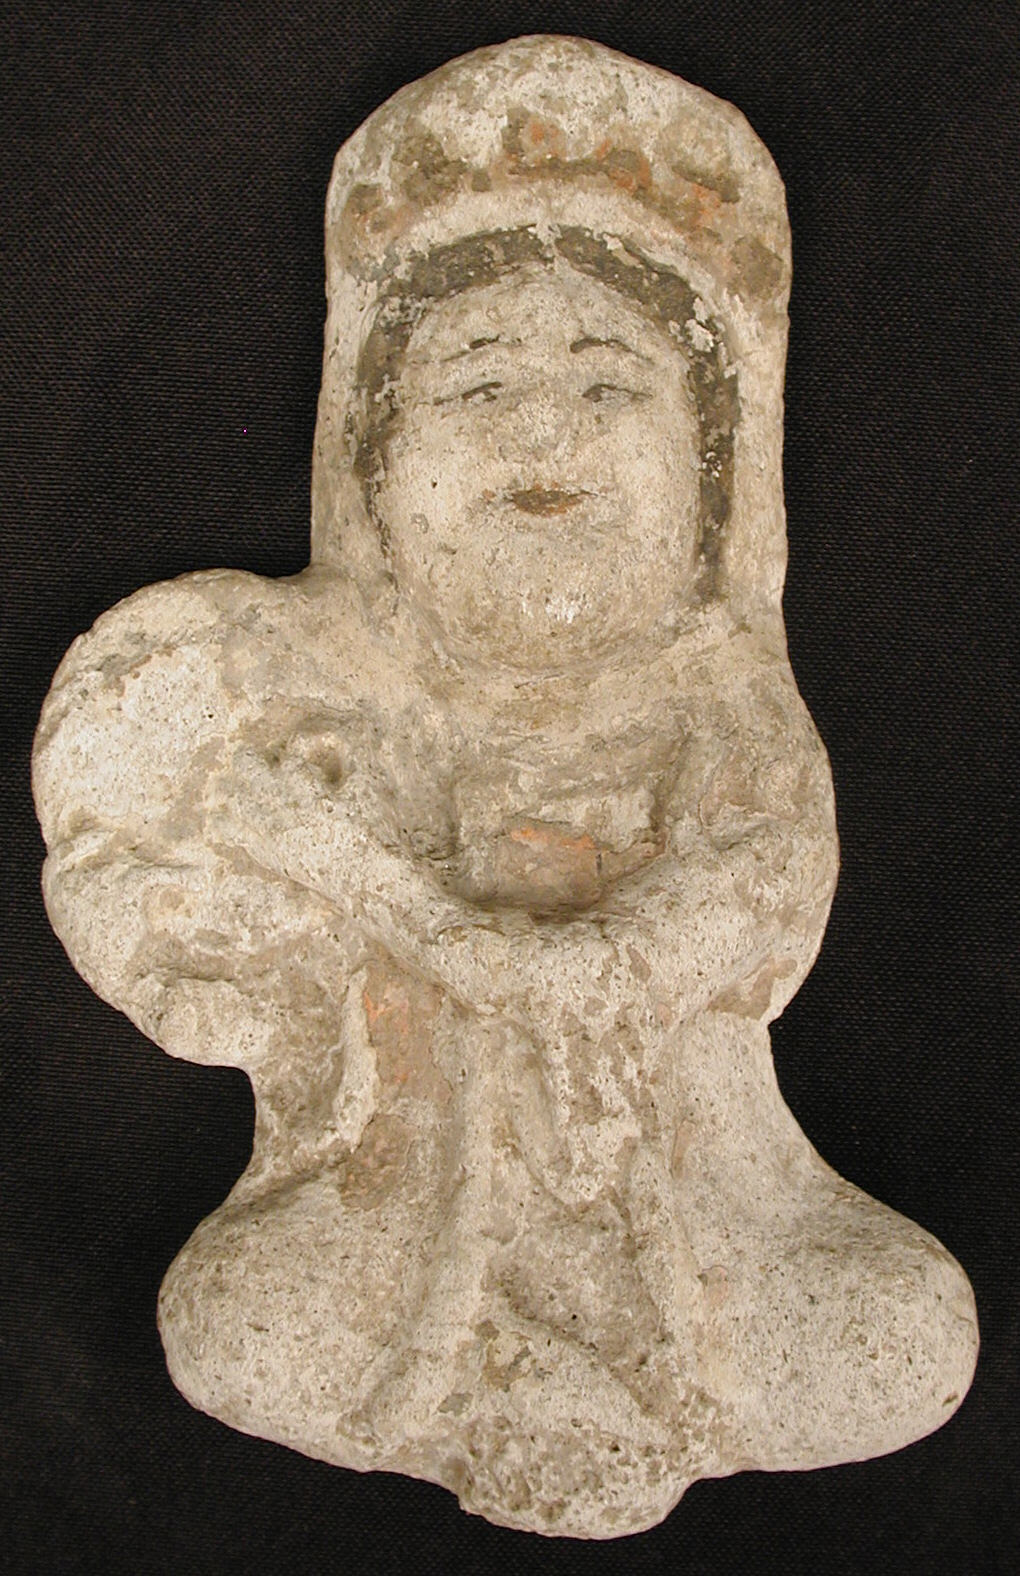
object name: figure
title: Seated Tambourine Player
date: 1101-1200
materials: plaster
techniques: molding, painting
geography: iran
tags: human figures,musical instruments